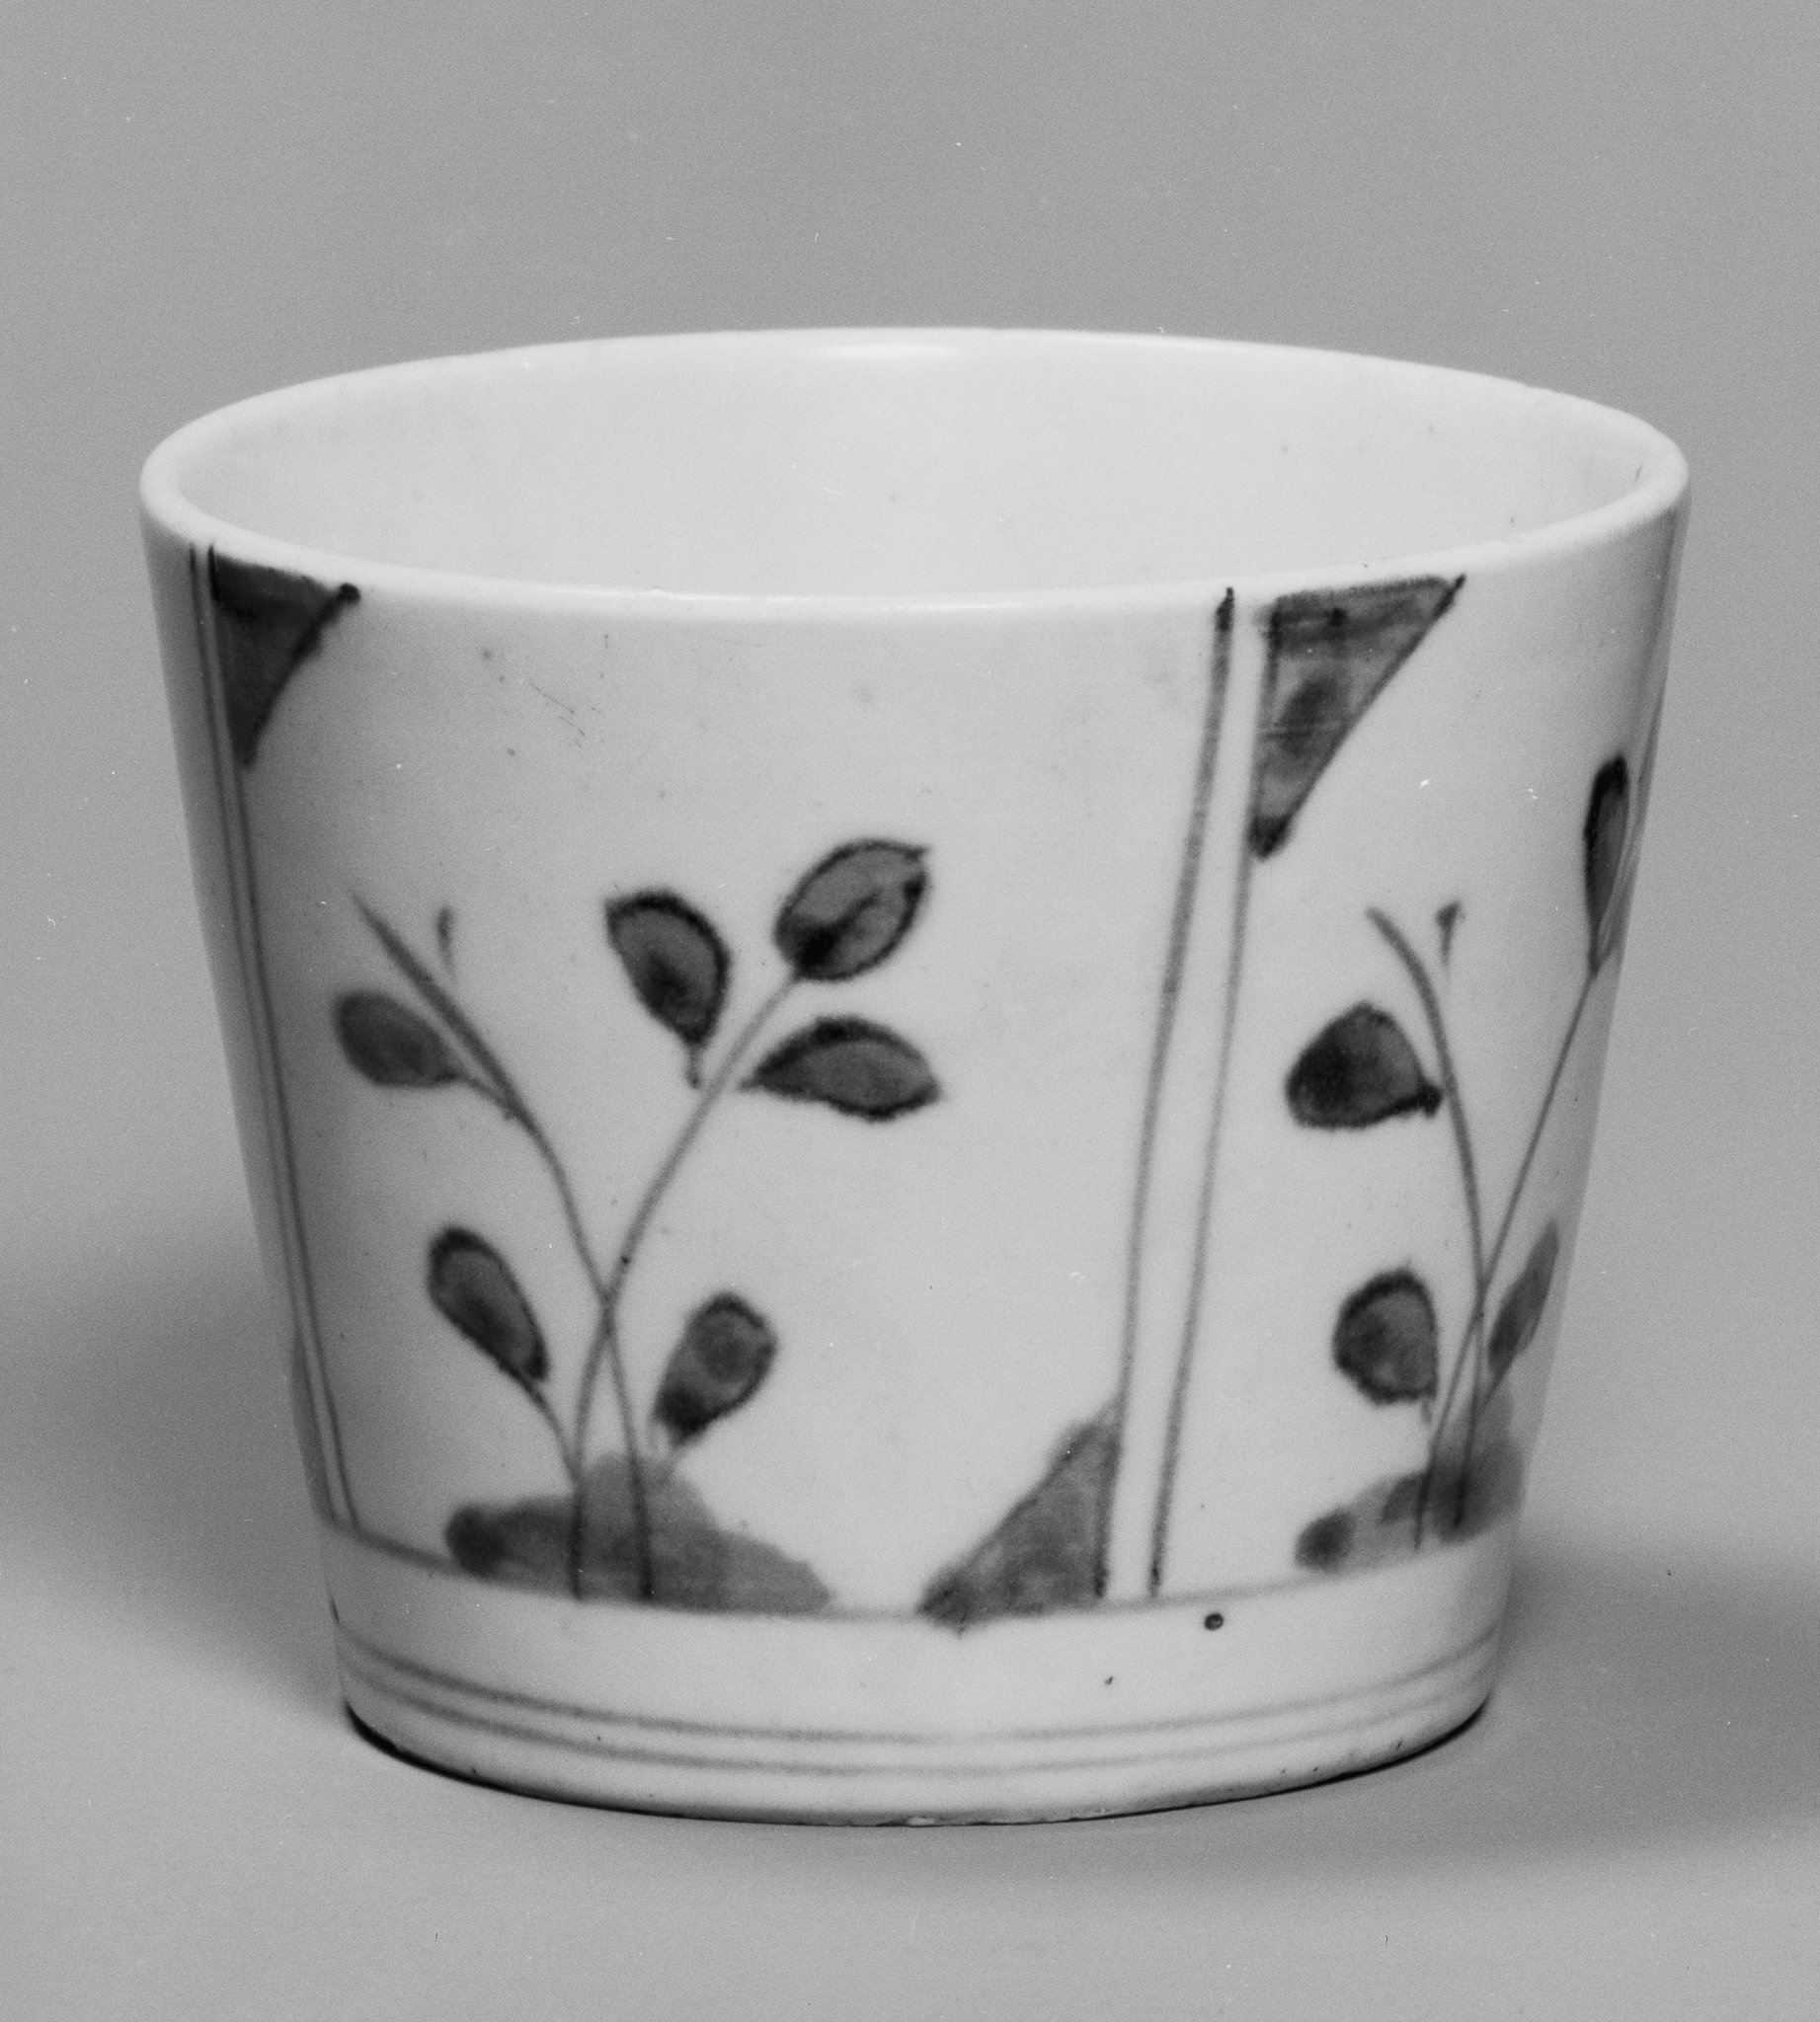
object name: soba cup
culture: japanese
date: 1701-1800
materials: porcelain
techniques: underglaze